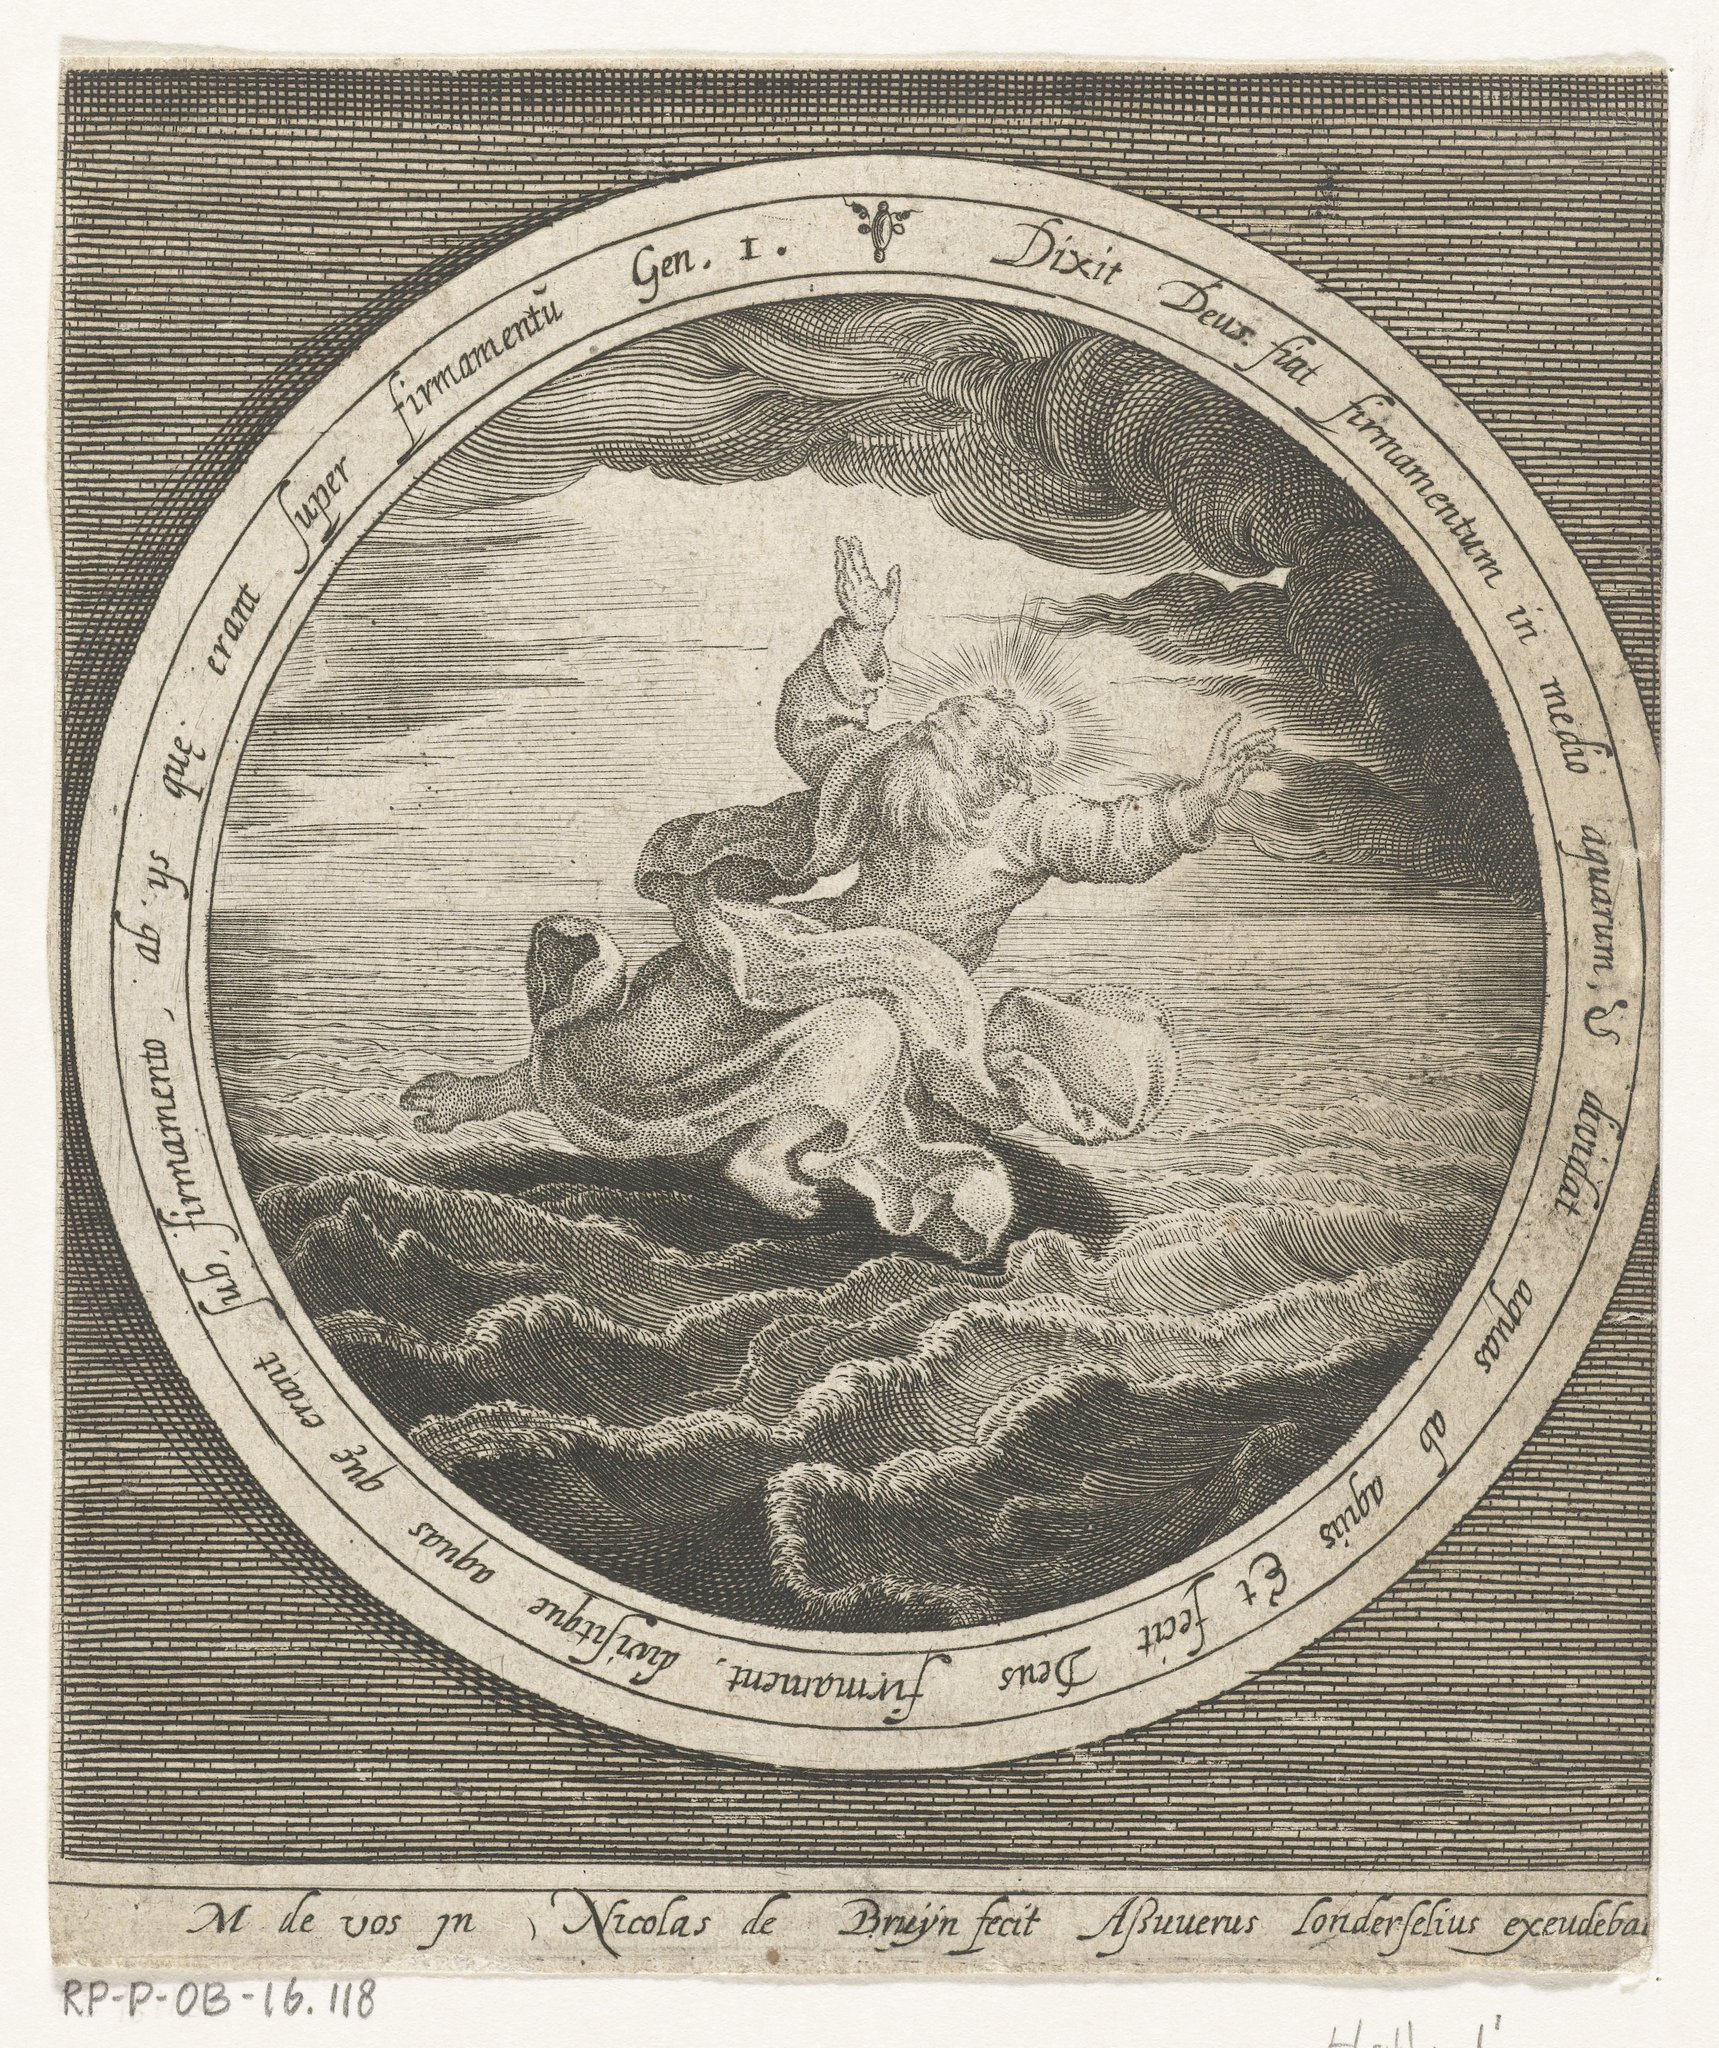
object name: print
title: Van schepping tot verdrijving uit paradijs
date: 1581-1656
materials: paper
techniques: engraving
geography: netherlands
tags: creation of the firmament and division of the waters above and below it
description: Tweede dag van schepping: God scheidt de watermassa's in hemel en zee. In medaillon met als opschrift een bijbeltekst in Latijn uit Genesis 1, binnen rechthoekige omlijsting.